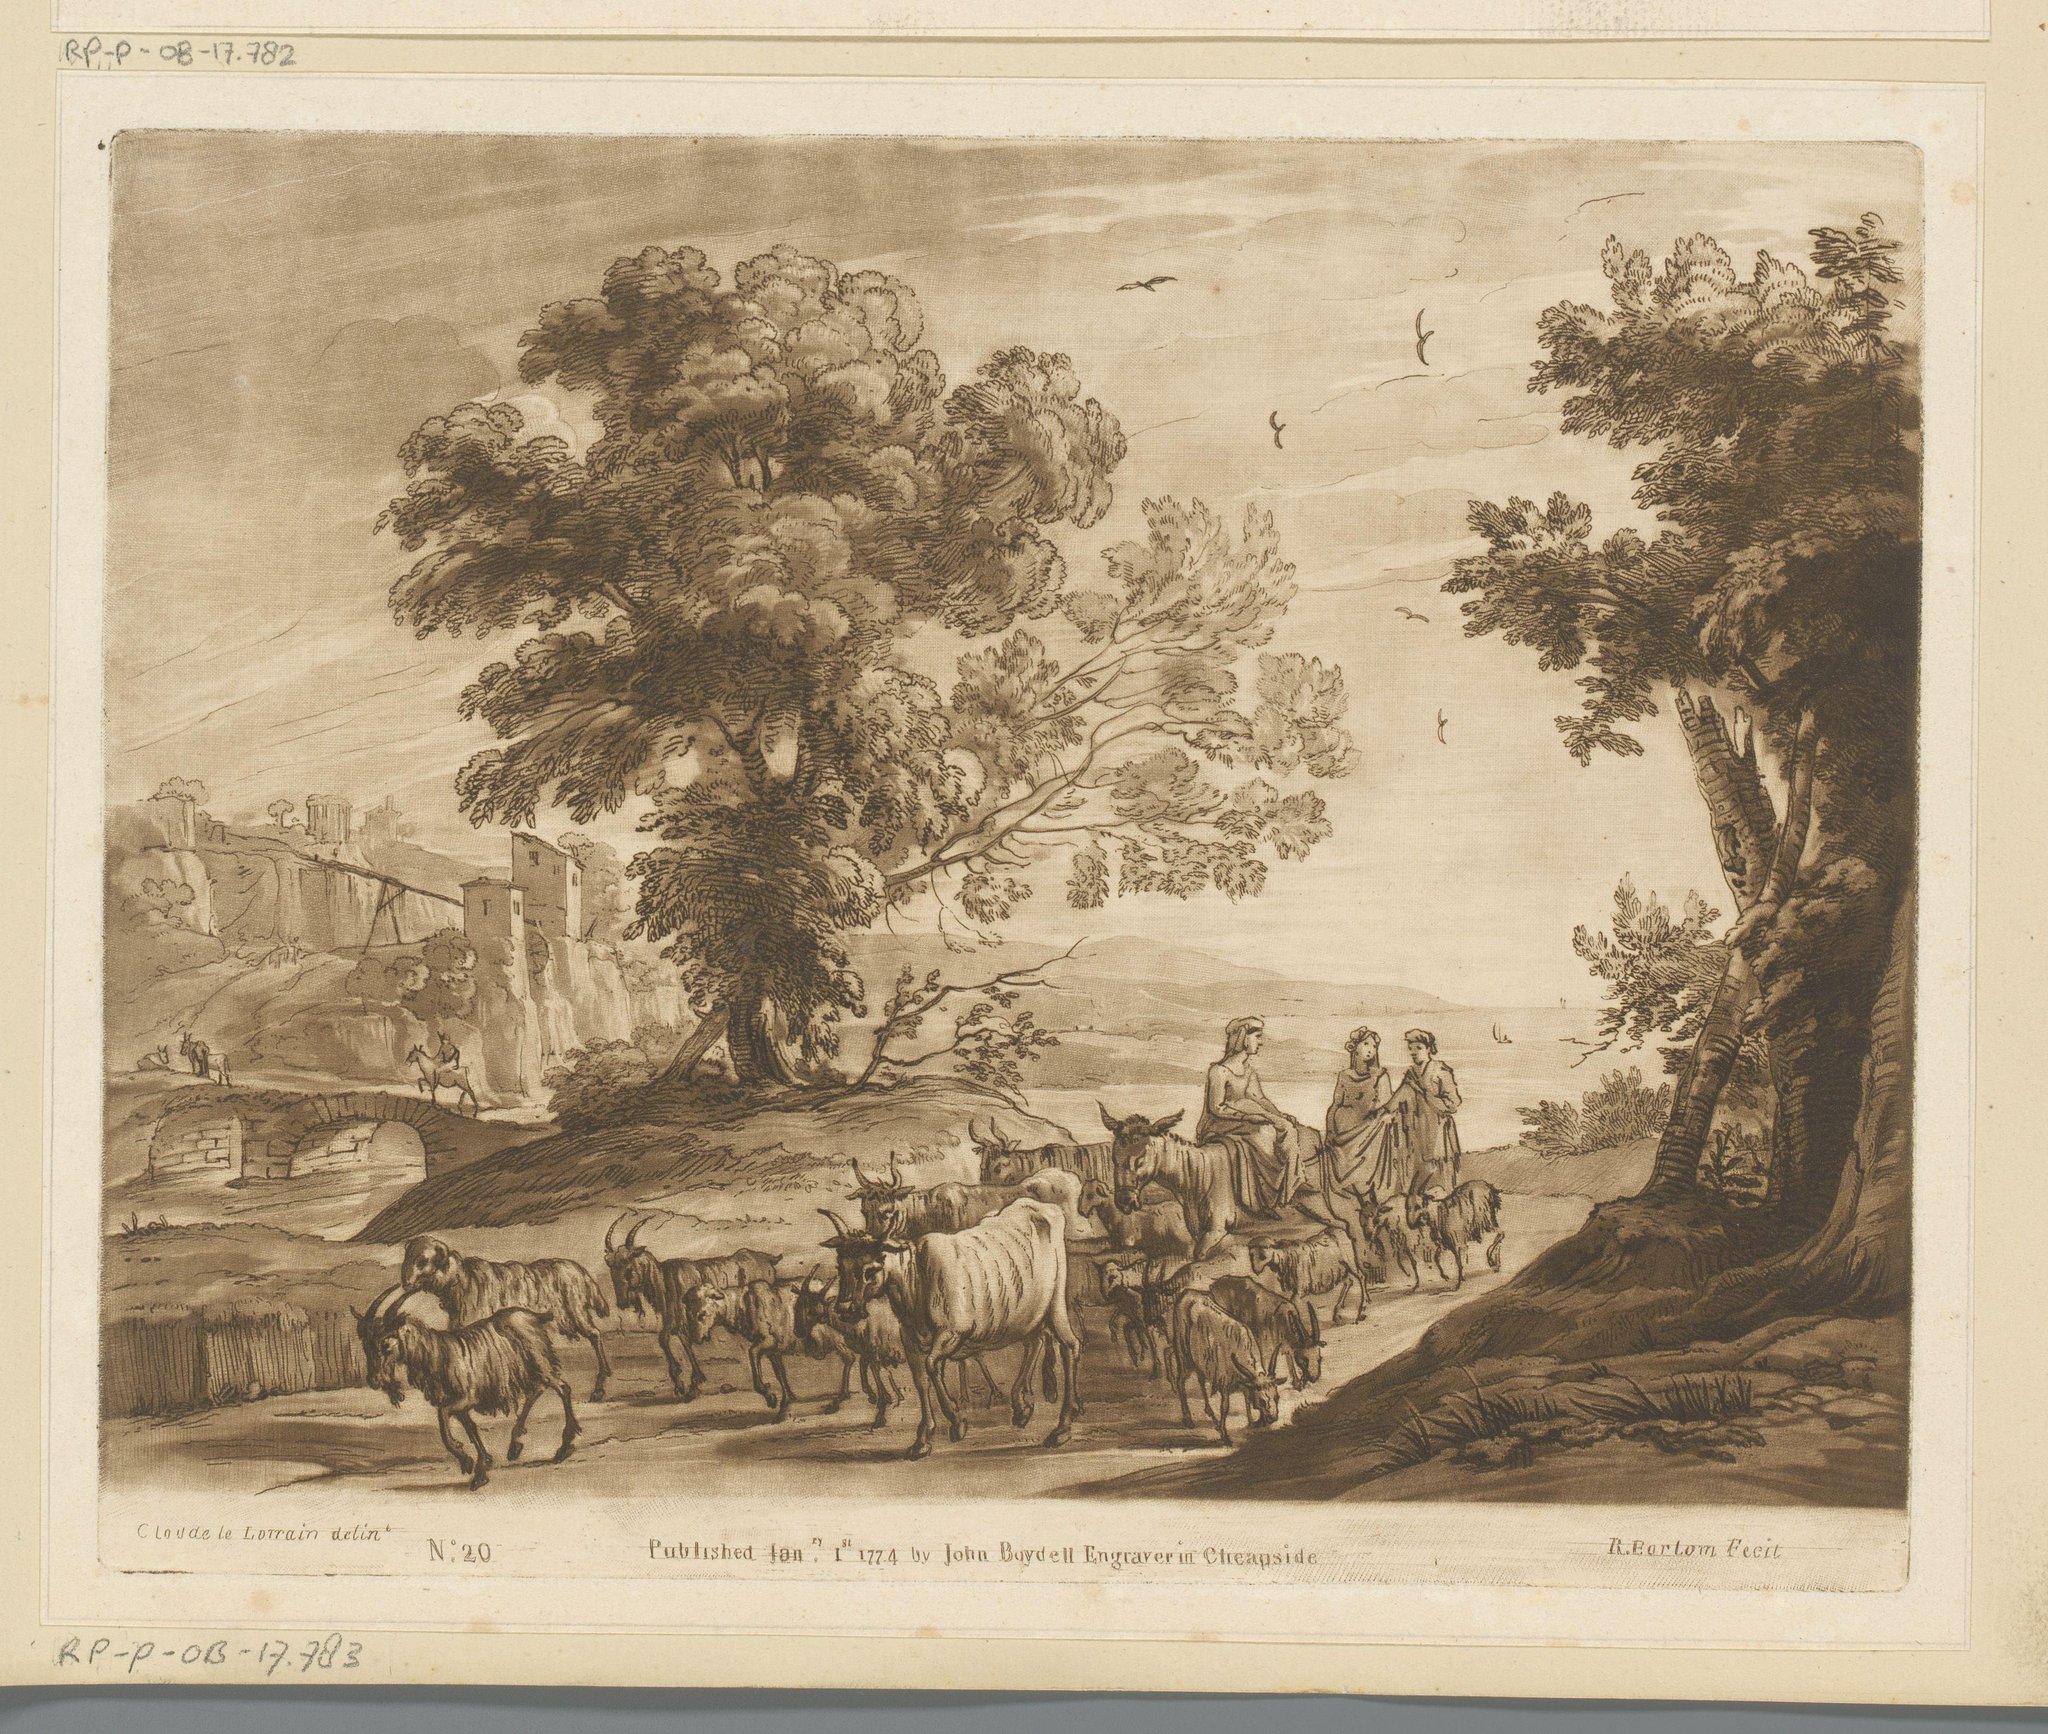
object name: print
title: Kustlandschap met herders en vee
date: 1774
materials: paper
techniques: etching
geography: london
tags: cattle, landscape with bridge, viaduct or aqueduct, coast, pastorals, arcadian scenes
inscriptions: date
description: Vanaf 1774 publiceerde John Boydell tweehonderd prenten naar het tekeningenboek Liber Veritatis van Claude Lorrain, in het bezit van de hertogen van Cavendish. Deze prenten werden vanaf 1777 in twee volumes gebundeld uitgegeven.